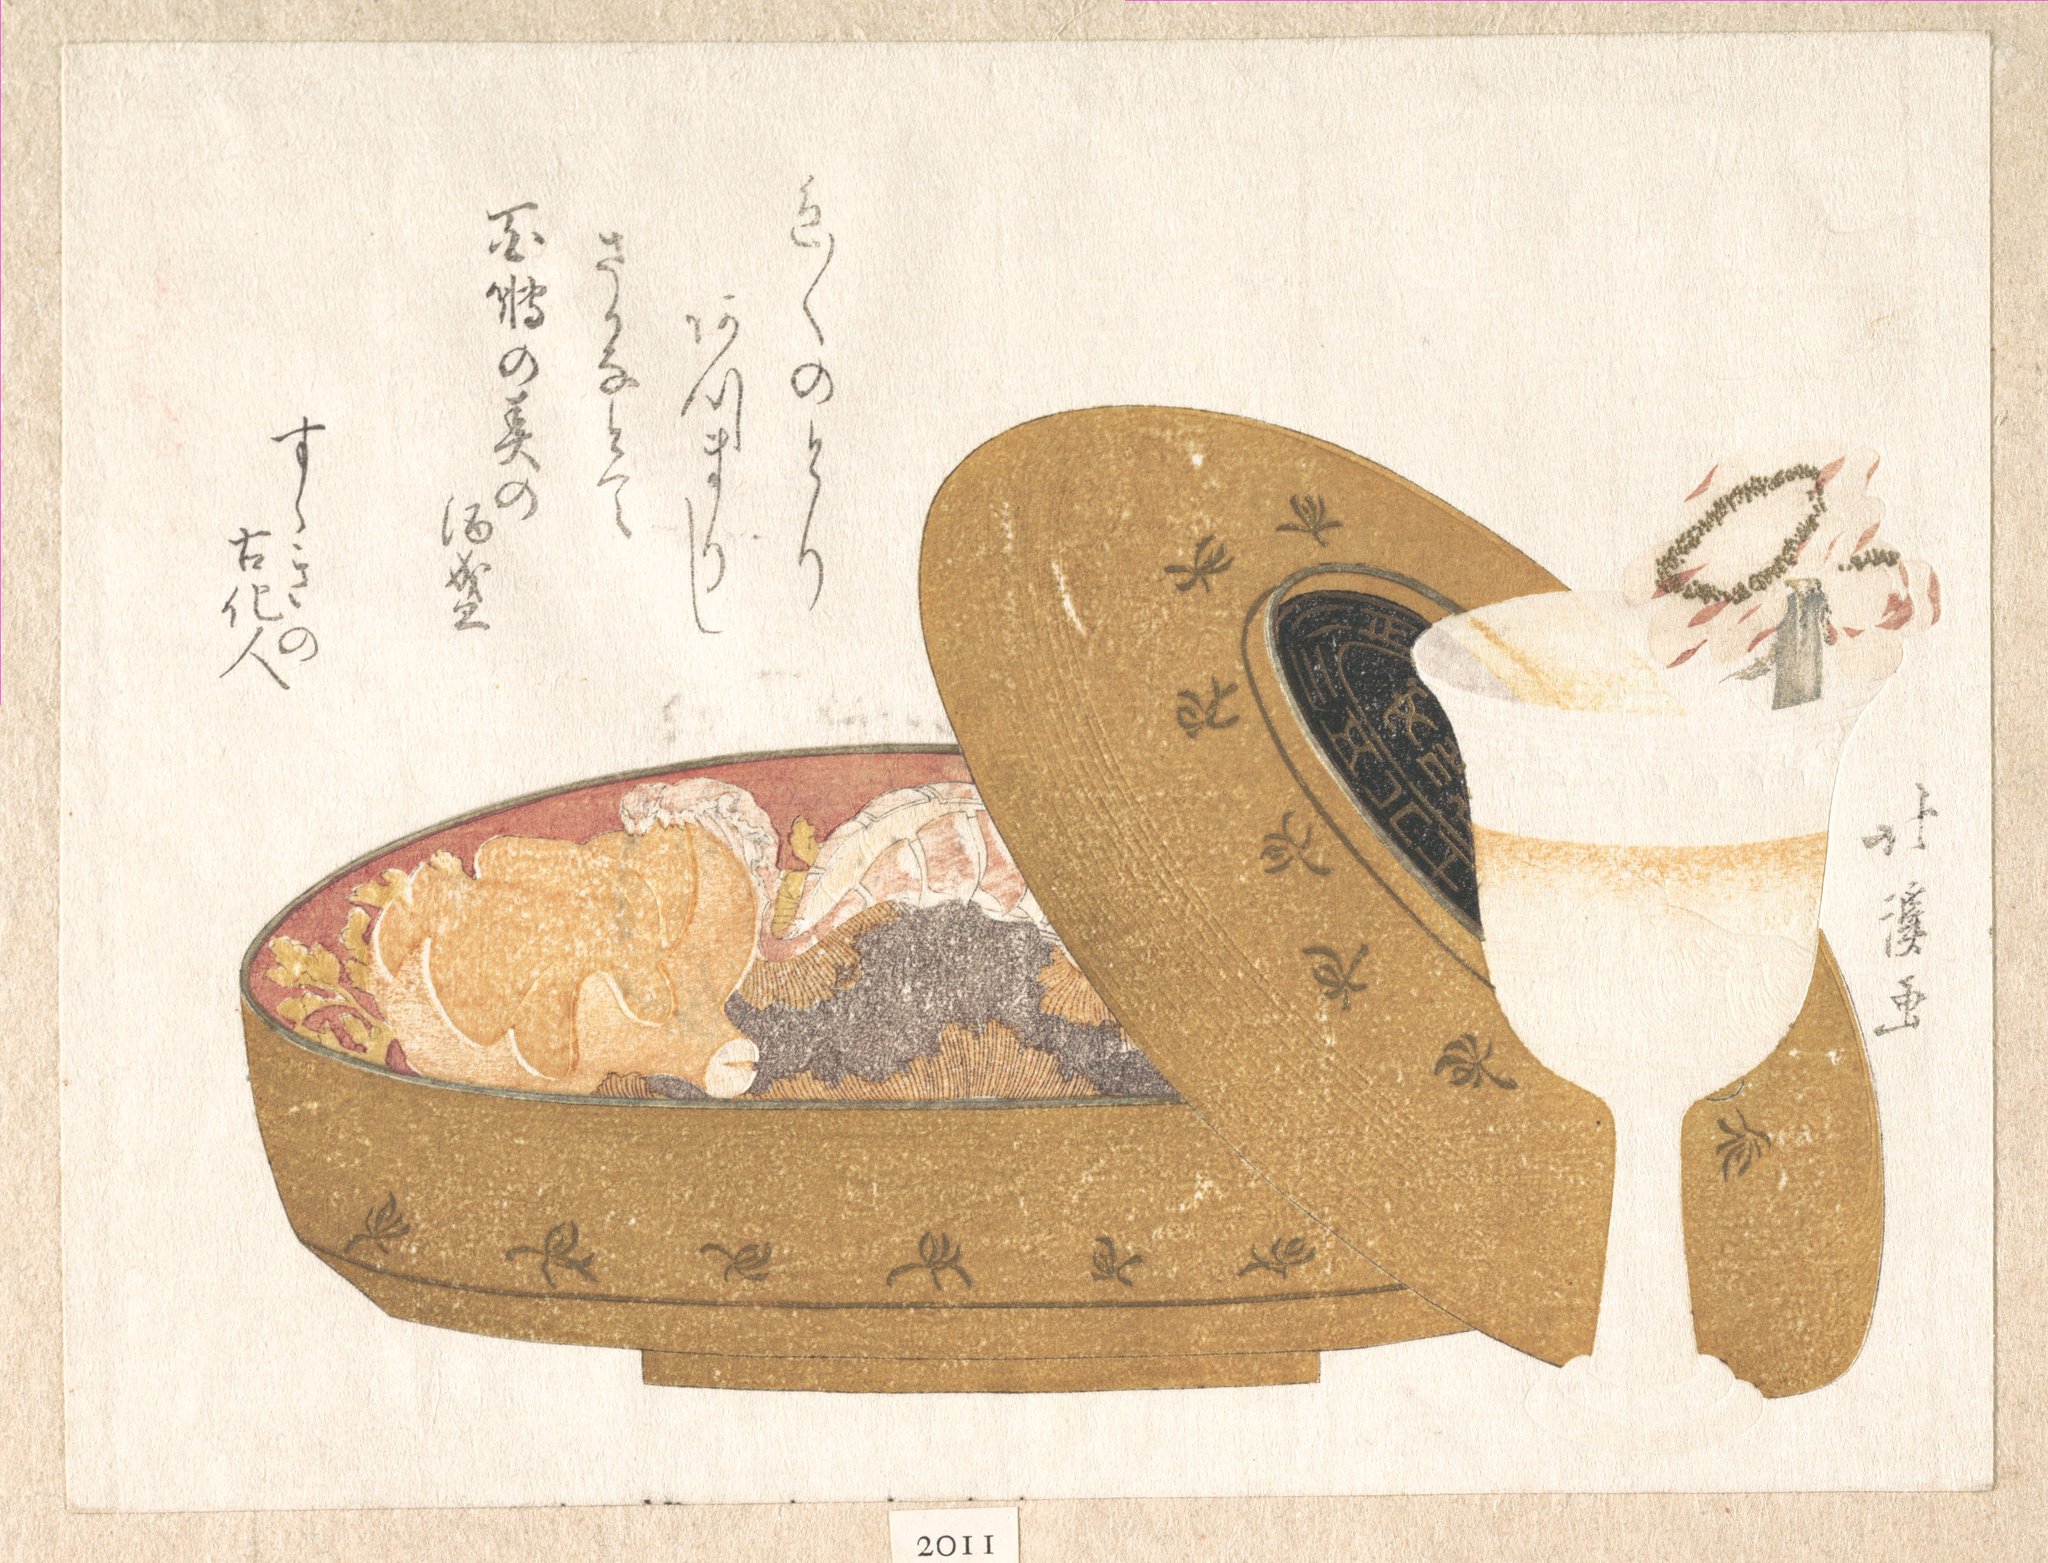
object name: woodblock print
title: Wine Goblet and Lacquer Food Box with New Year’s Meal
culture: japanese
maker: totoya hokkei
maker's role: artist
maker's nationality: japanese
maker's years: 1780-1850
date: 1811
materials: ink, paper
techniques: surimono, woodblock print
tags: food,wine,goblets